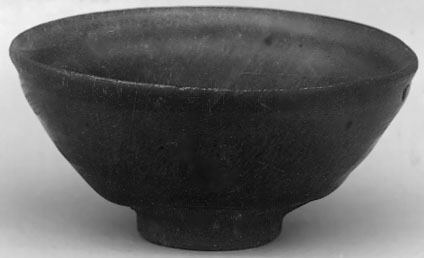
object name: teabowl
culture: japanese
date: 1801-1900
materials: clay, glaze